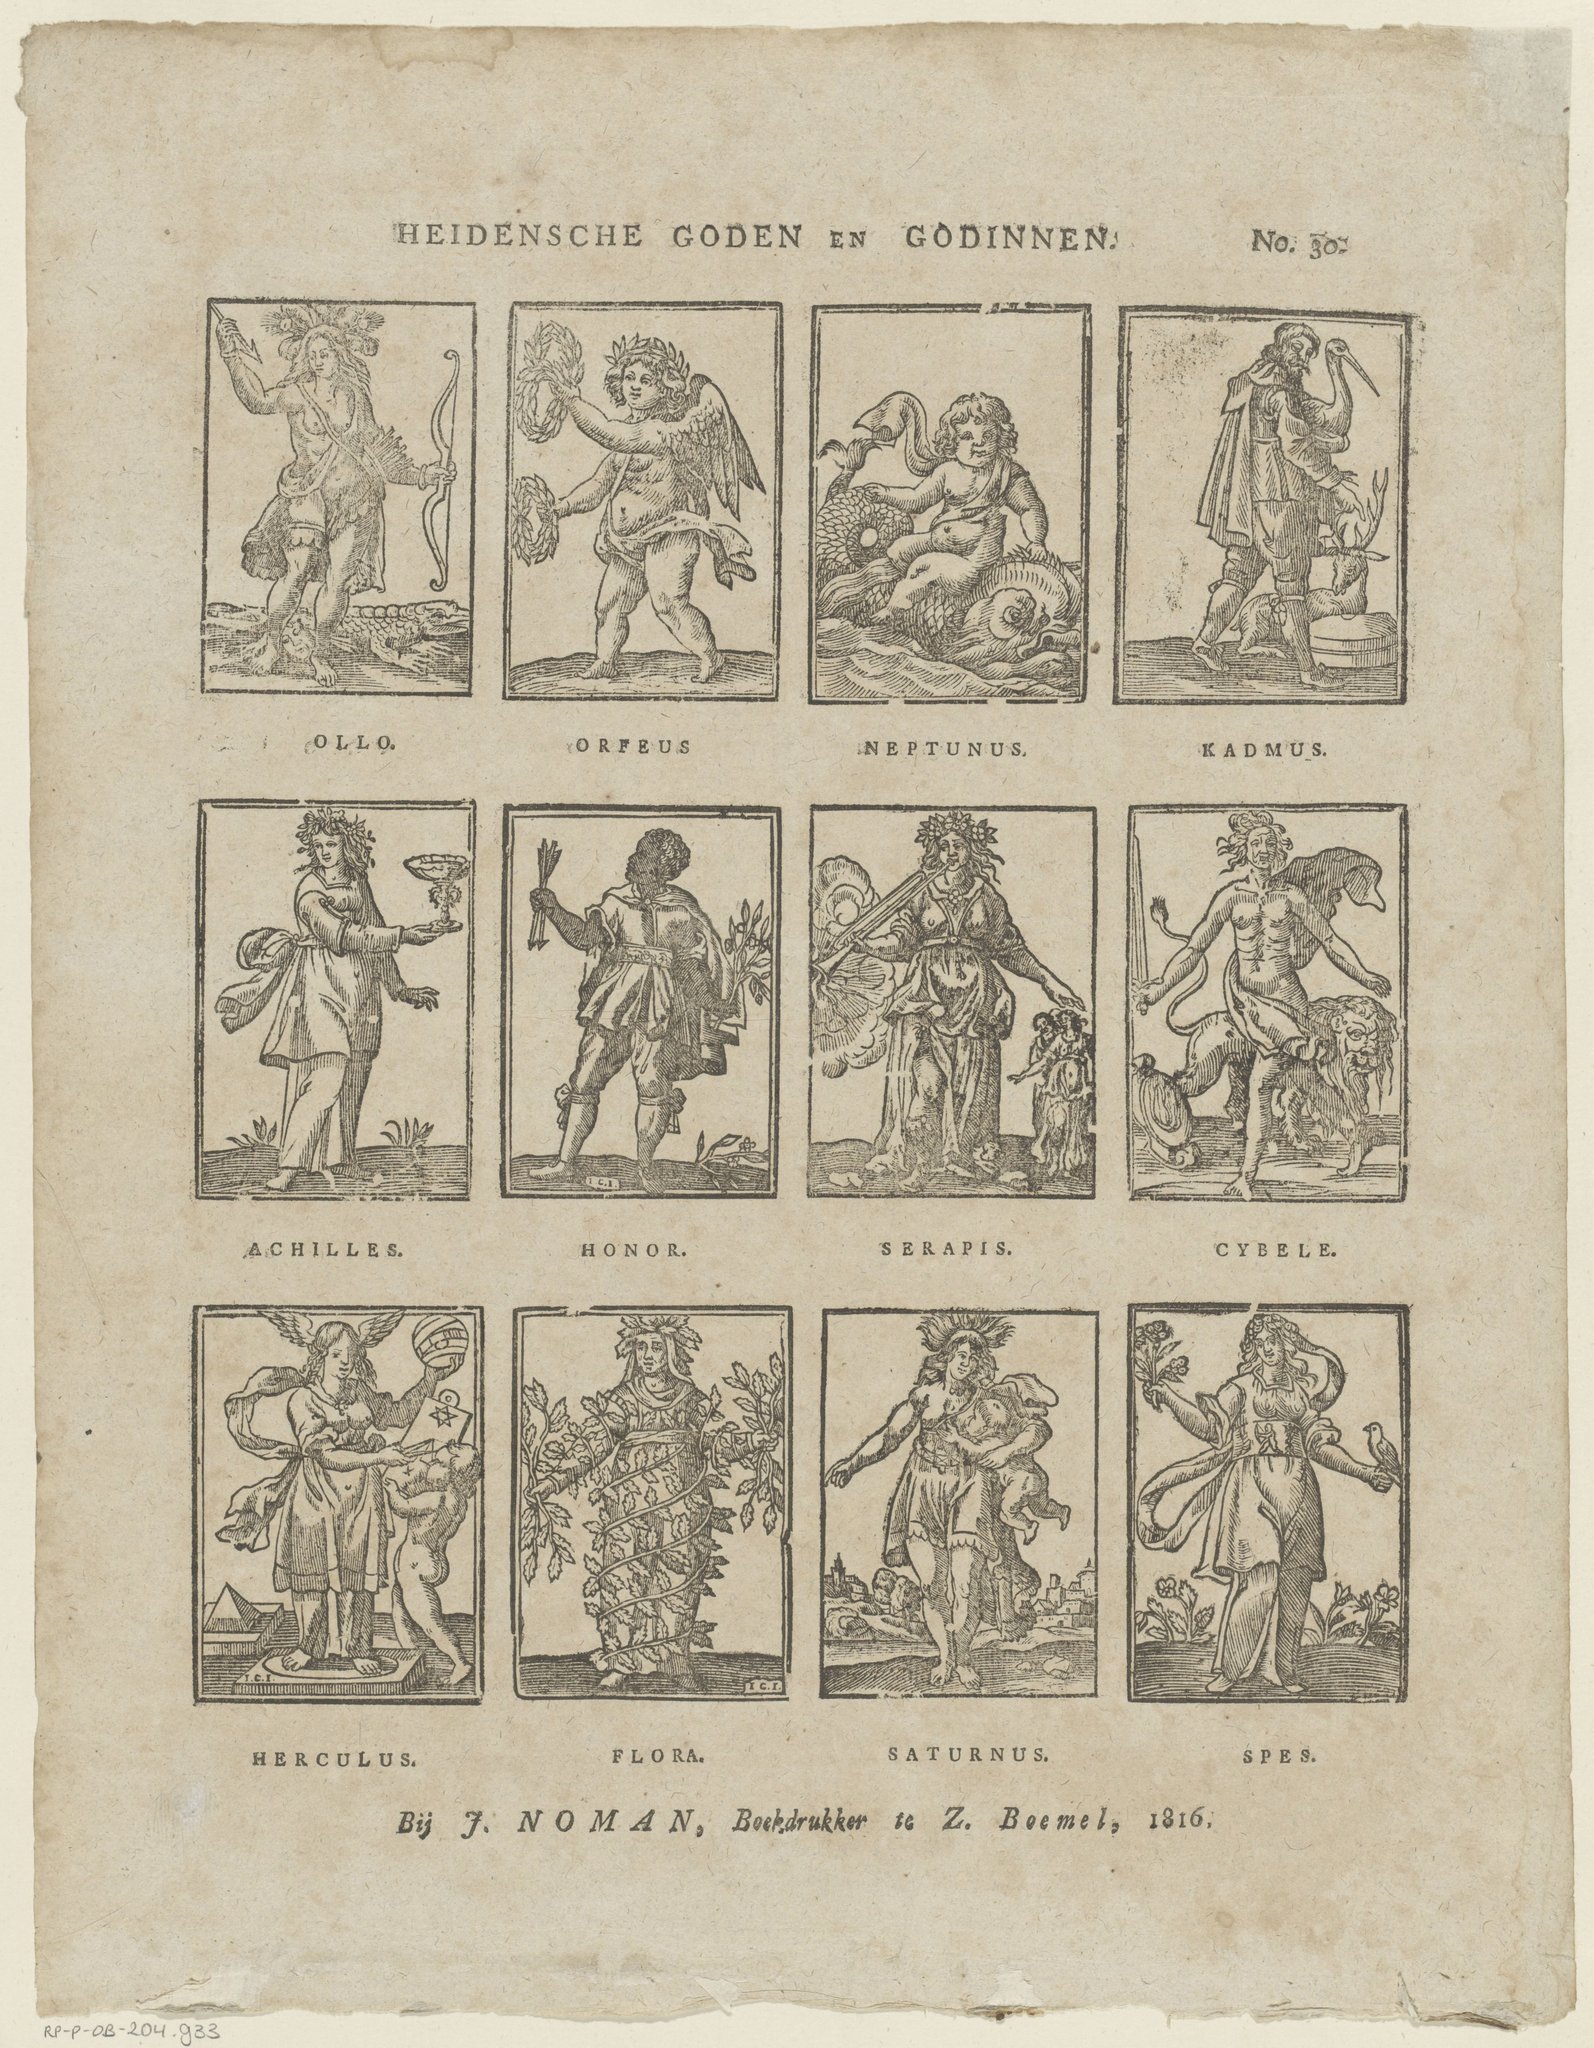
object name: print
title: Heidensche goden en godinnen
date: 1806-1830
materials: paper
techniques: letterpress printing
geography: zaltbommel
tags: (story of) hercules (heracles), (story of) saturn (cronus), (story of) apollo (phoebus), serapis, gods ~ classical mythology, (story of) flora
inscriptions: collector's mark: Lugt 2760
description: Blad met 12 voorstellingen van mythologische figuren, onder wie Apollo, Hercules en Flora. Onder elke afbeelding een onderschrift. Genummerd rechtsboven: No. 30.